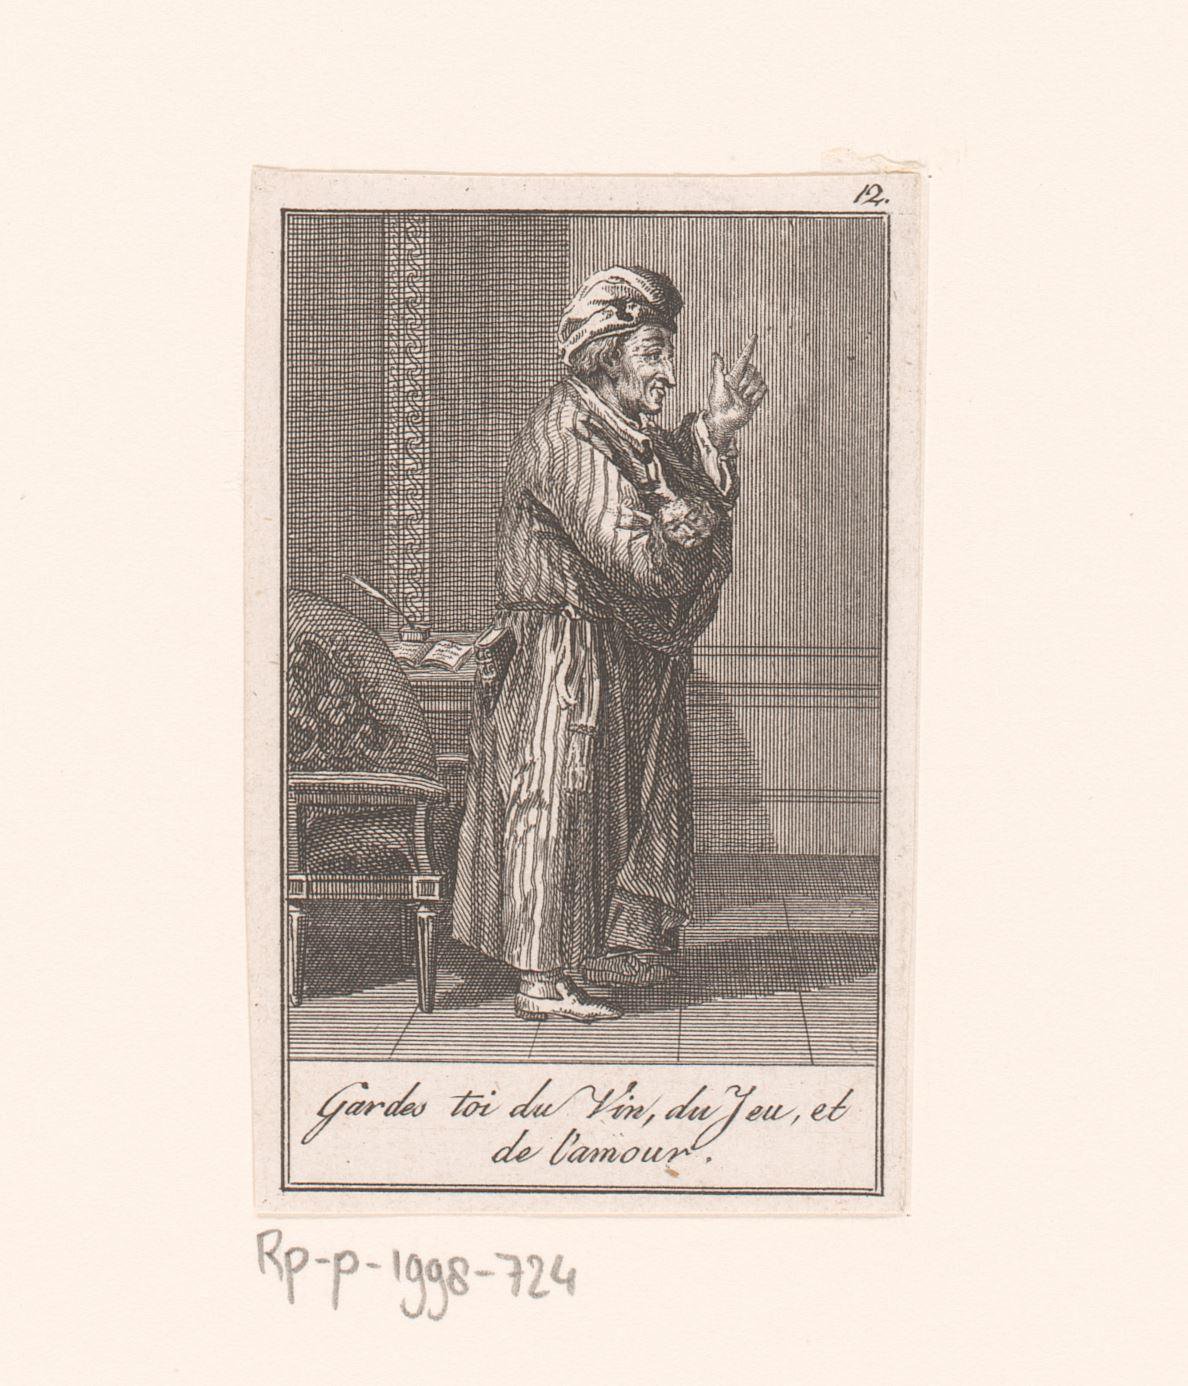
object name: print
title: Gardes toi, du Vin, du jeu, et de l'amour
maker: karl heinrich grünler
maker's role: print maker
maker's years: 1761-1823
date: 1771-1823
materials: paper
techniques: etching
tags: adult man, index finger forwards, pointing, indicating, bath-robe, dressing-gown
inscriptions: collector's mark: Lugt 2228